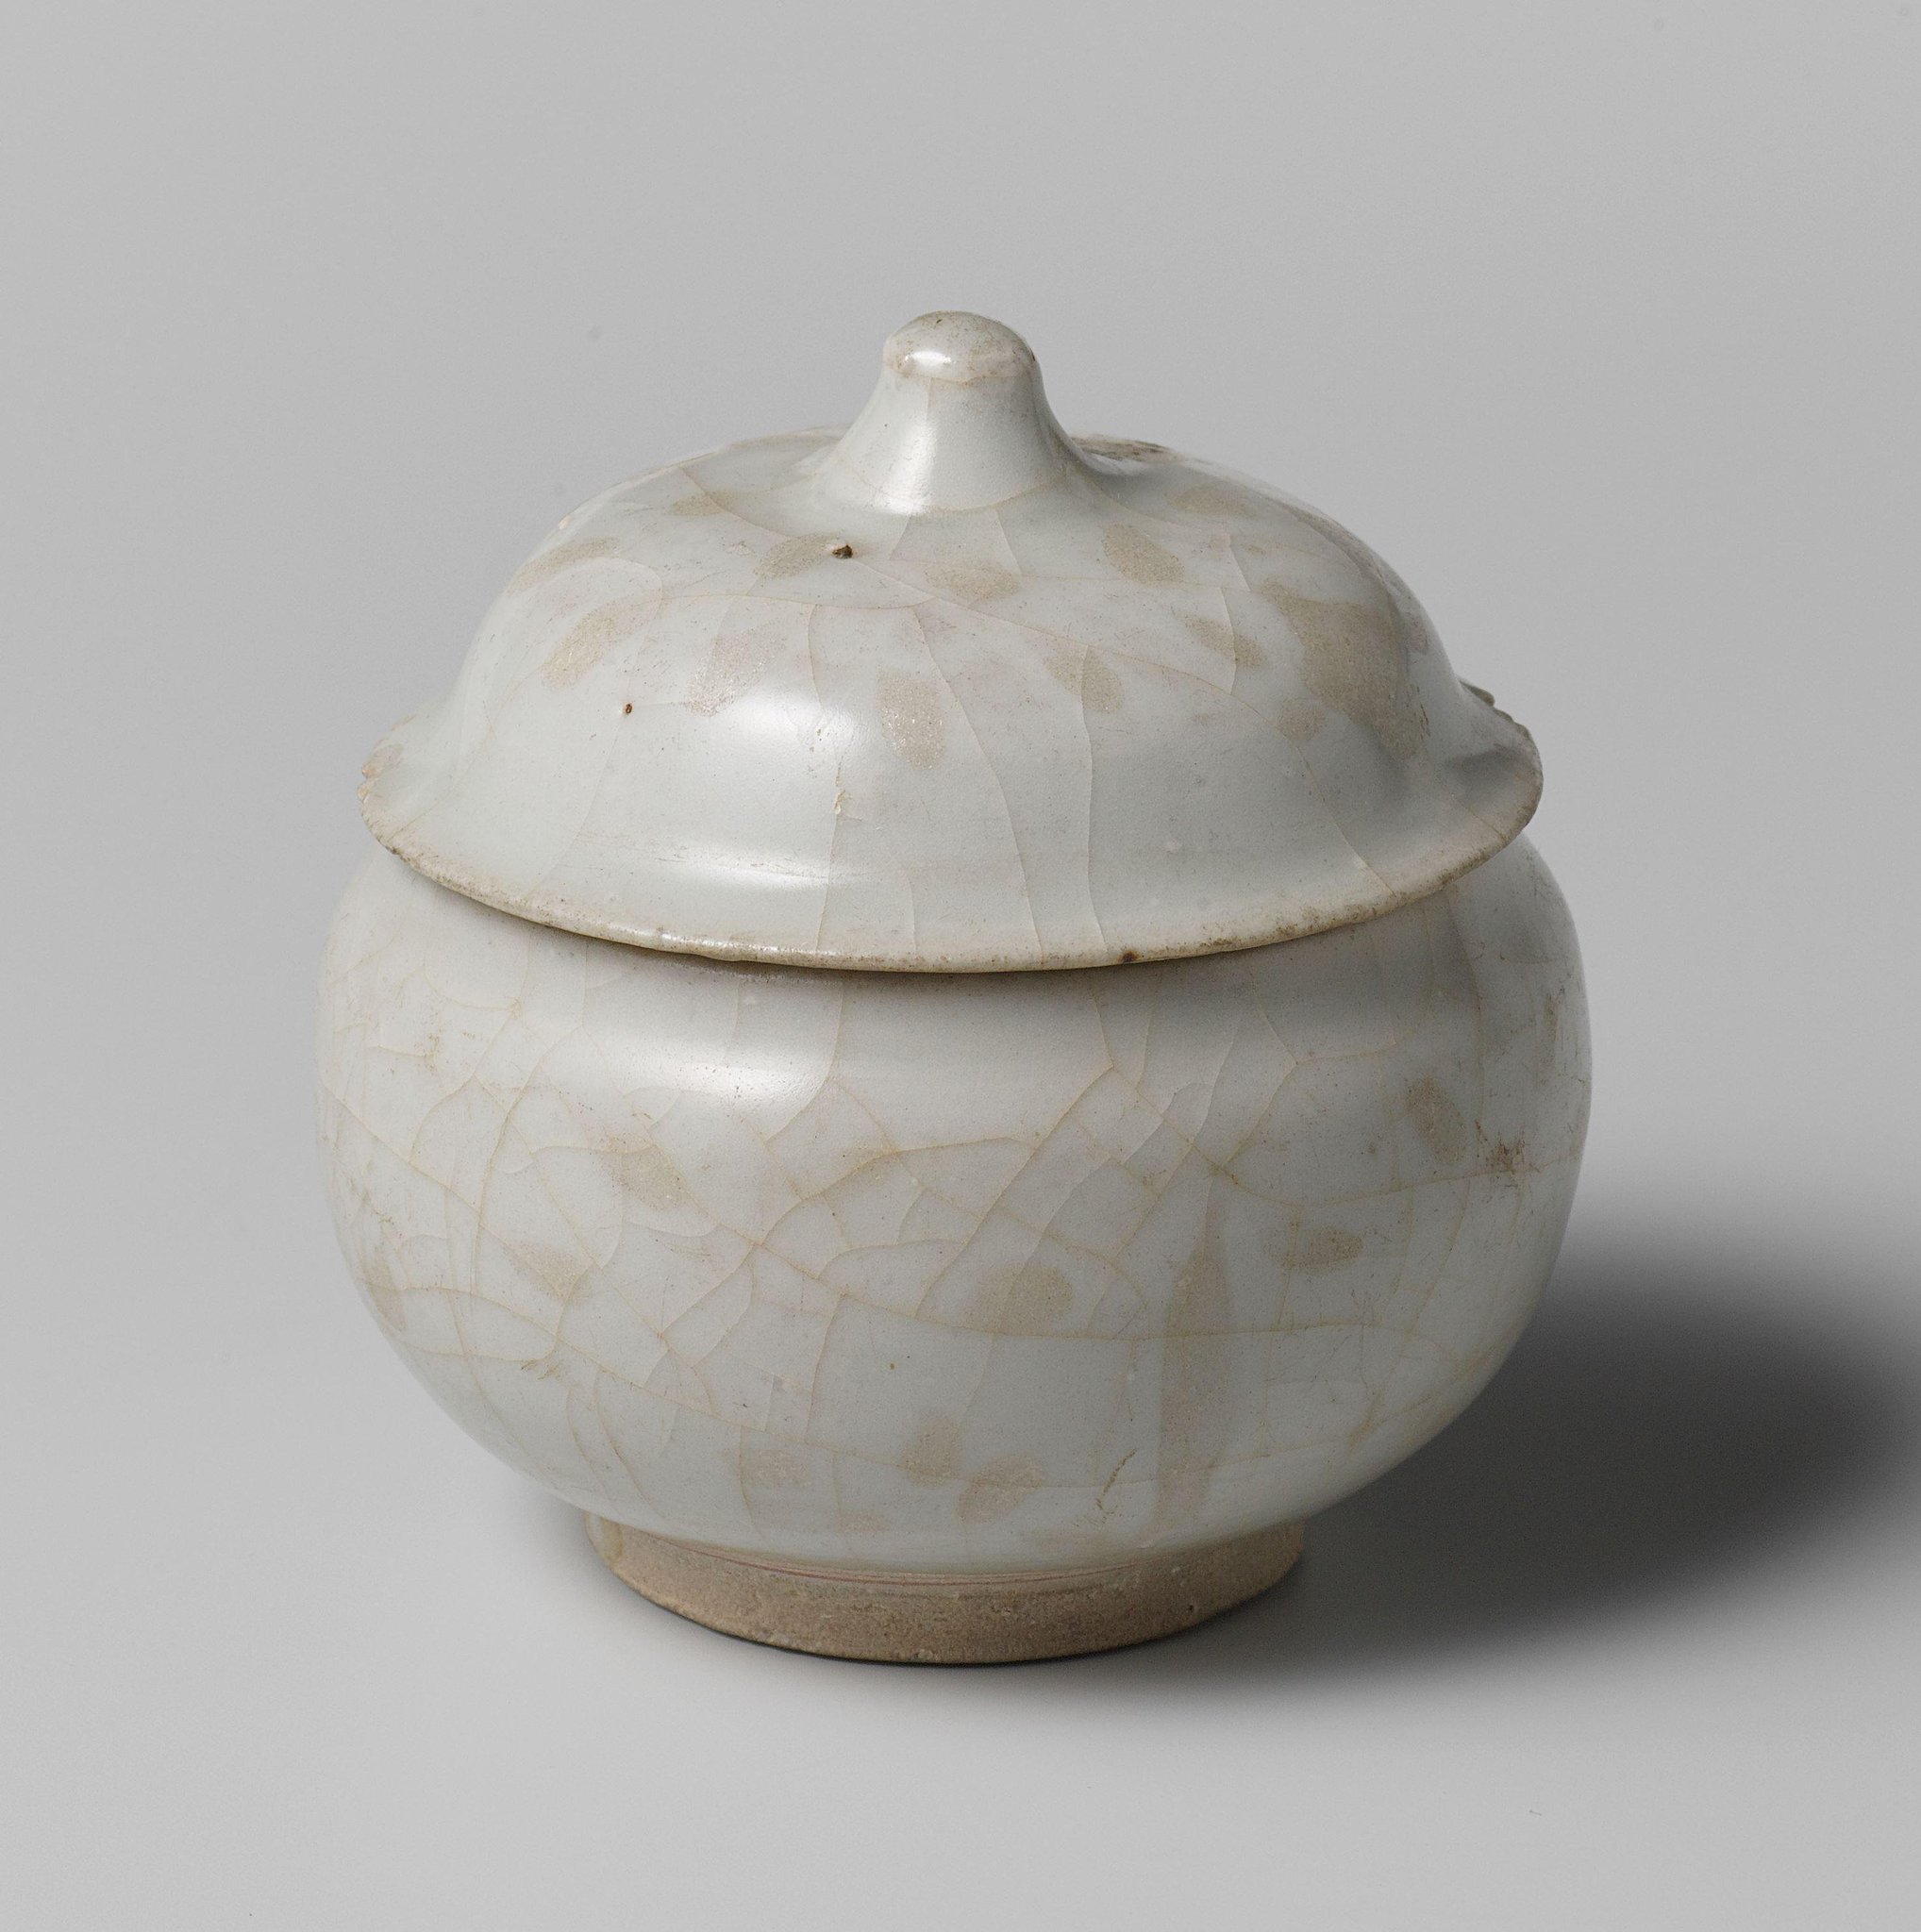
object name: covered jar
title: Covered jar with a bluish white glaze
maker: Anonymous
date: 1279-1368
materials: glaze, stoneware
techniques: firing, turning, vitrification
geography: china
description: Deksel van pot van steengoed met een bolvormige wand, bedekt met een gecraqueleerd, transparant glazuur met een blauwwitte tint. Op het glazuur onregelmatige vlekjes. Qingbai.